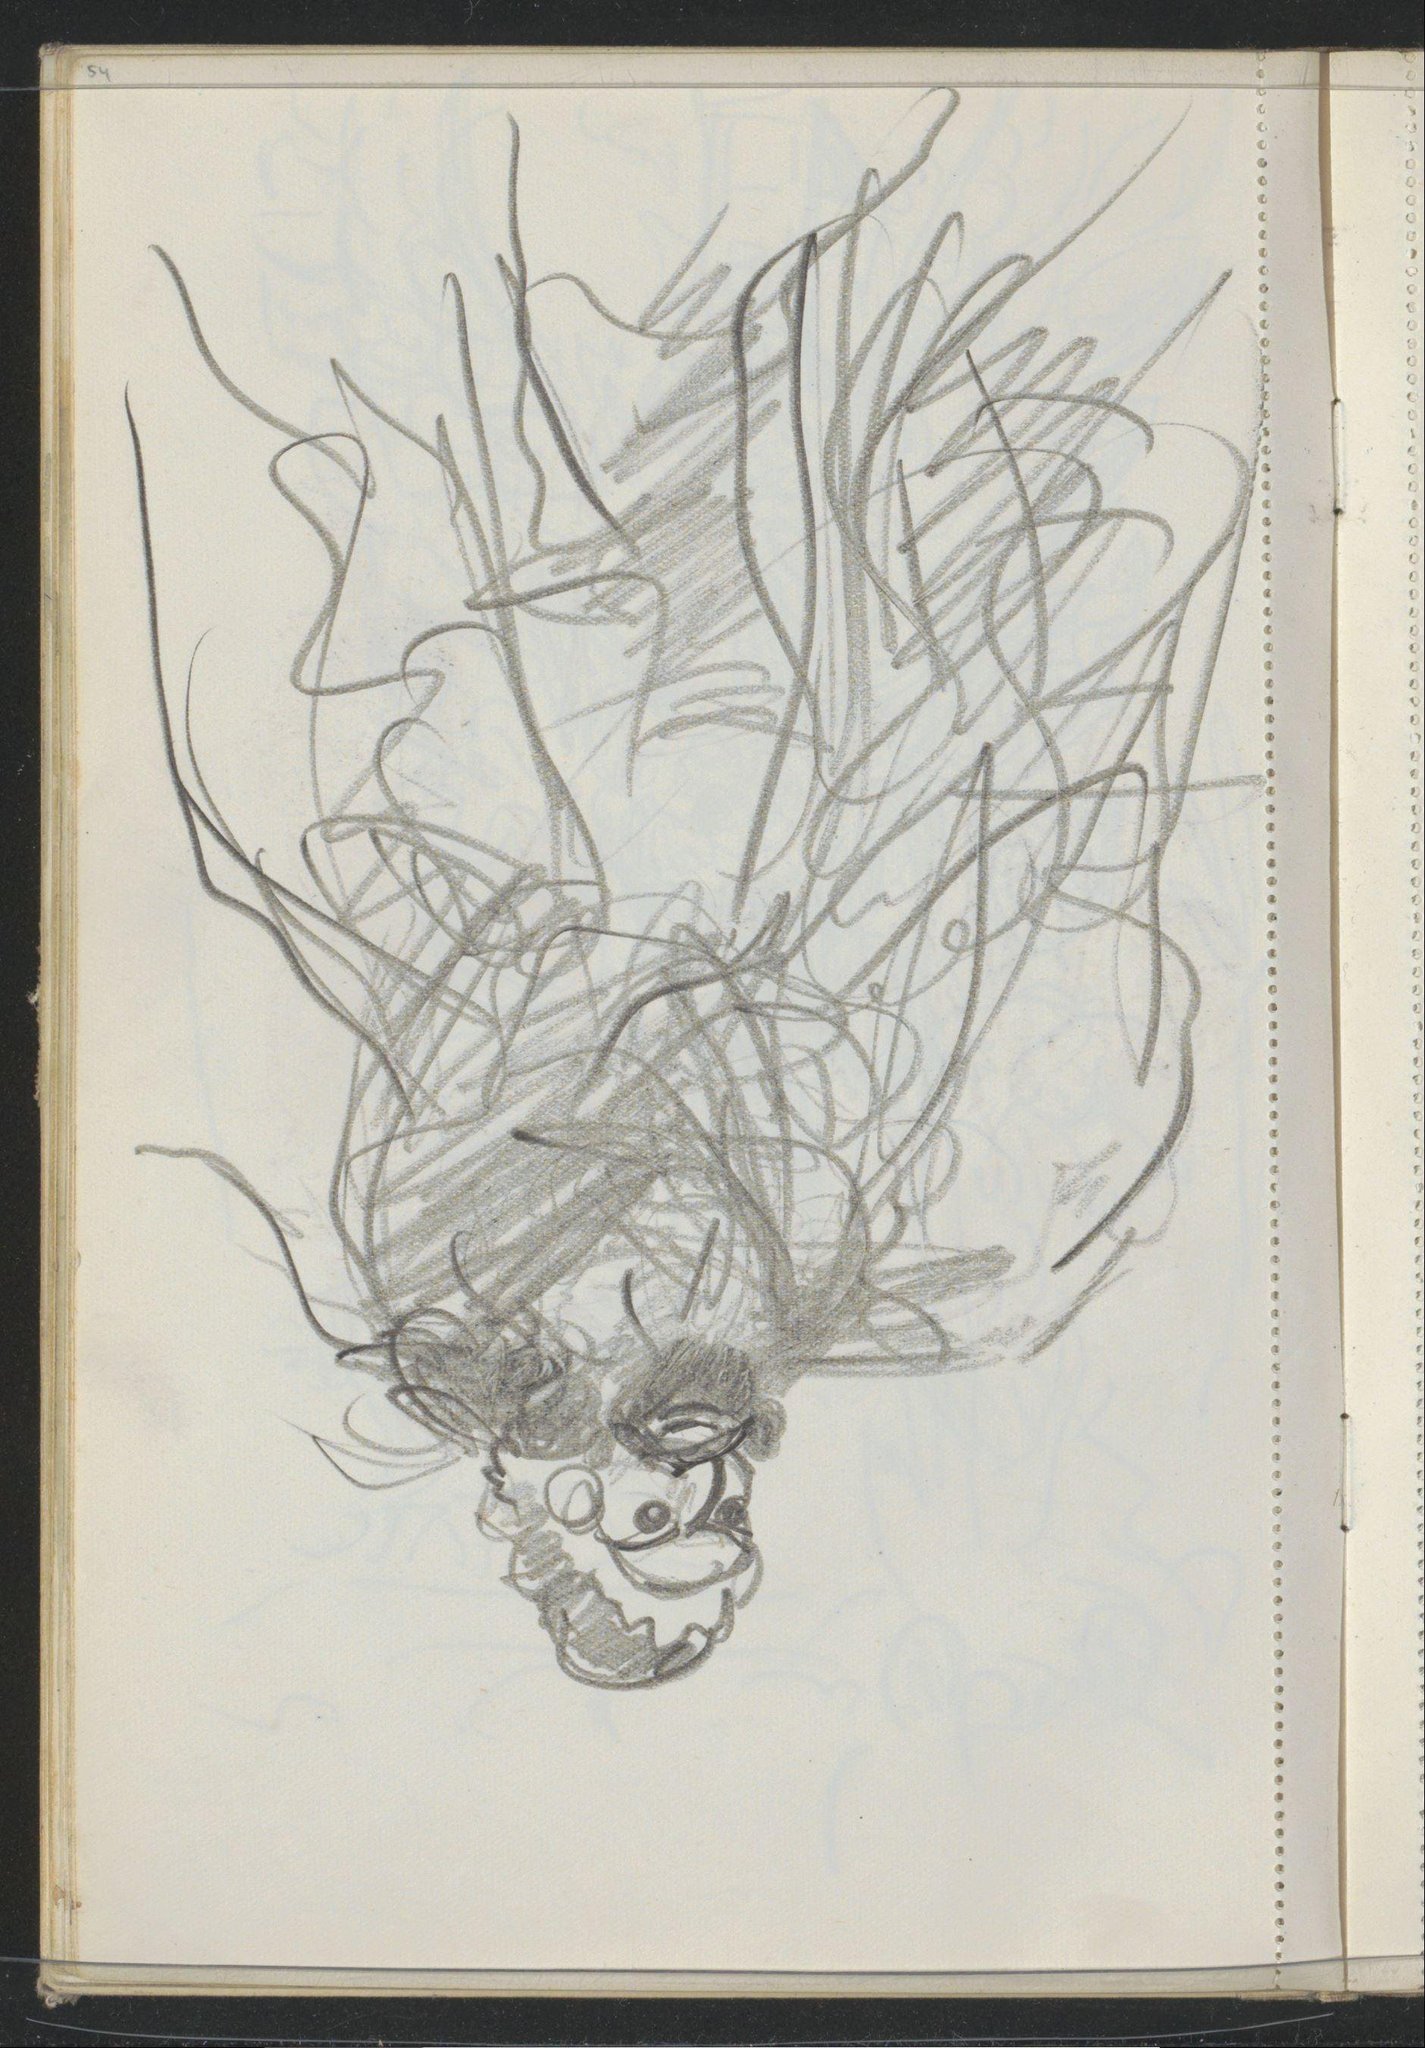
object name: sketchbook leaf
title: Man met een baard en mantel, van voren gezien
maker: marius bauer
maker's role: draughtsman, print maker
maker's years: 1867-1932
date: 1925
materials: paper, pencil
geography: indonesia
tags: adult man, beard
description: Pagina 54 uit een schetsboek met 74 bladen.